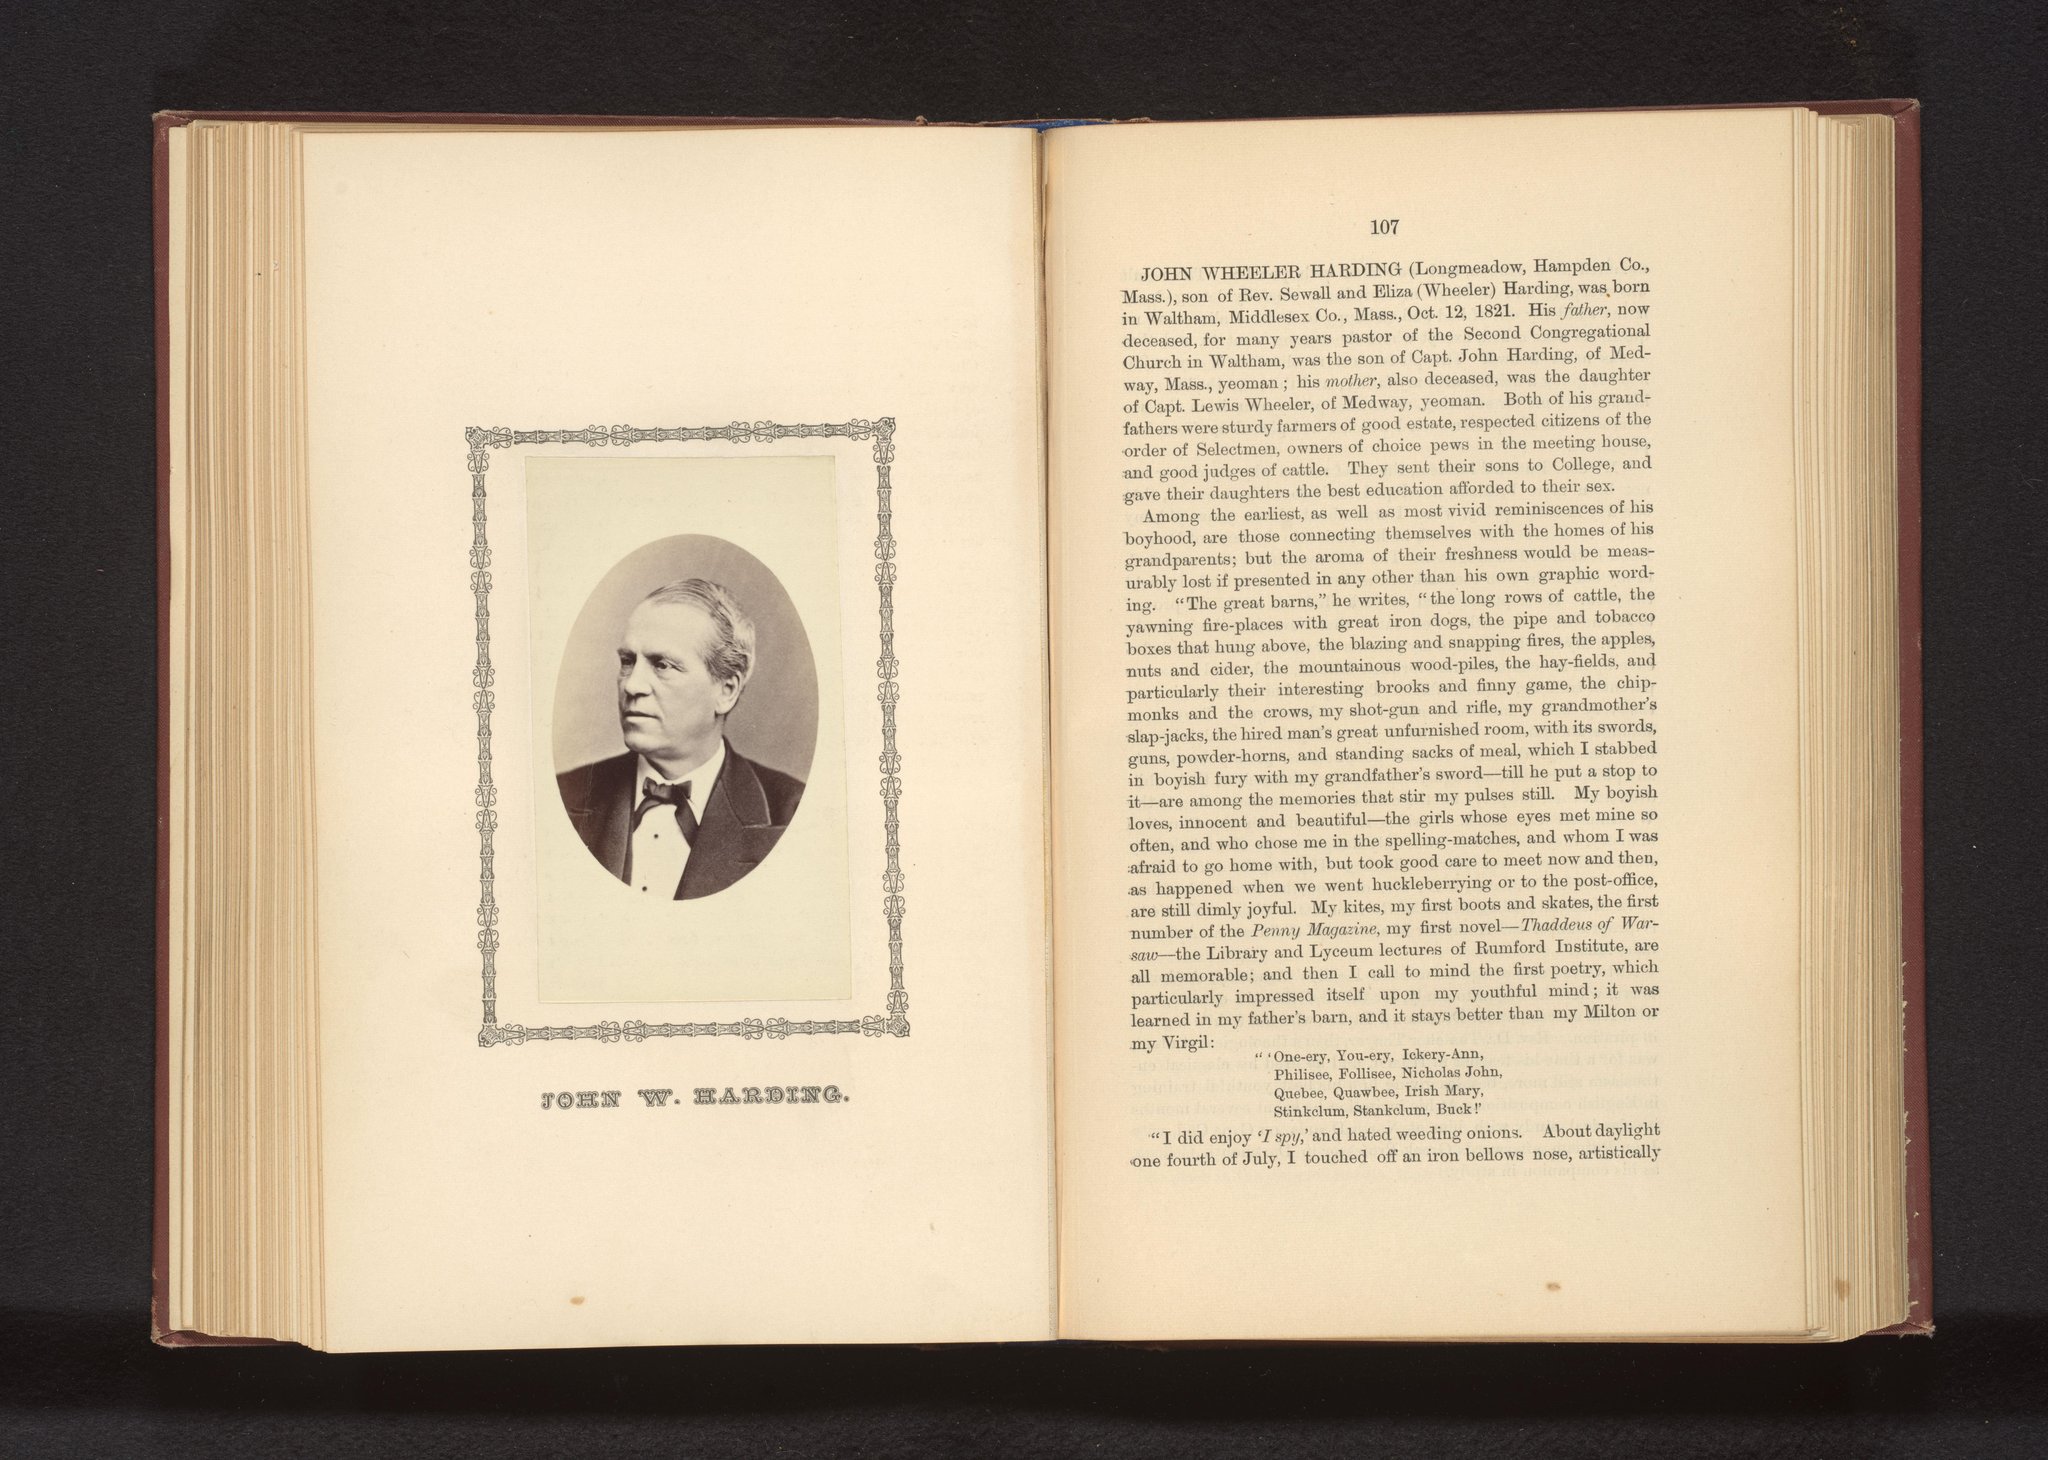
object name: photograph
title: John W. Harding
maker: Anonymous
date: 1876-1881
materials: photographic support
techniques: albumen print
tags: adult man